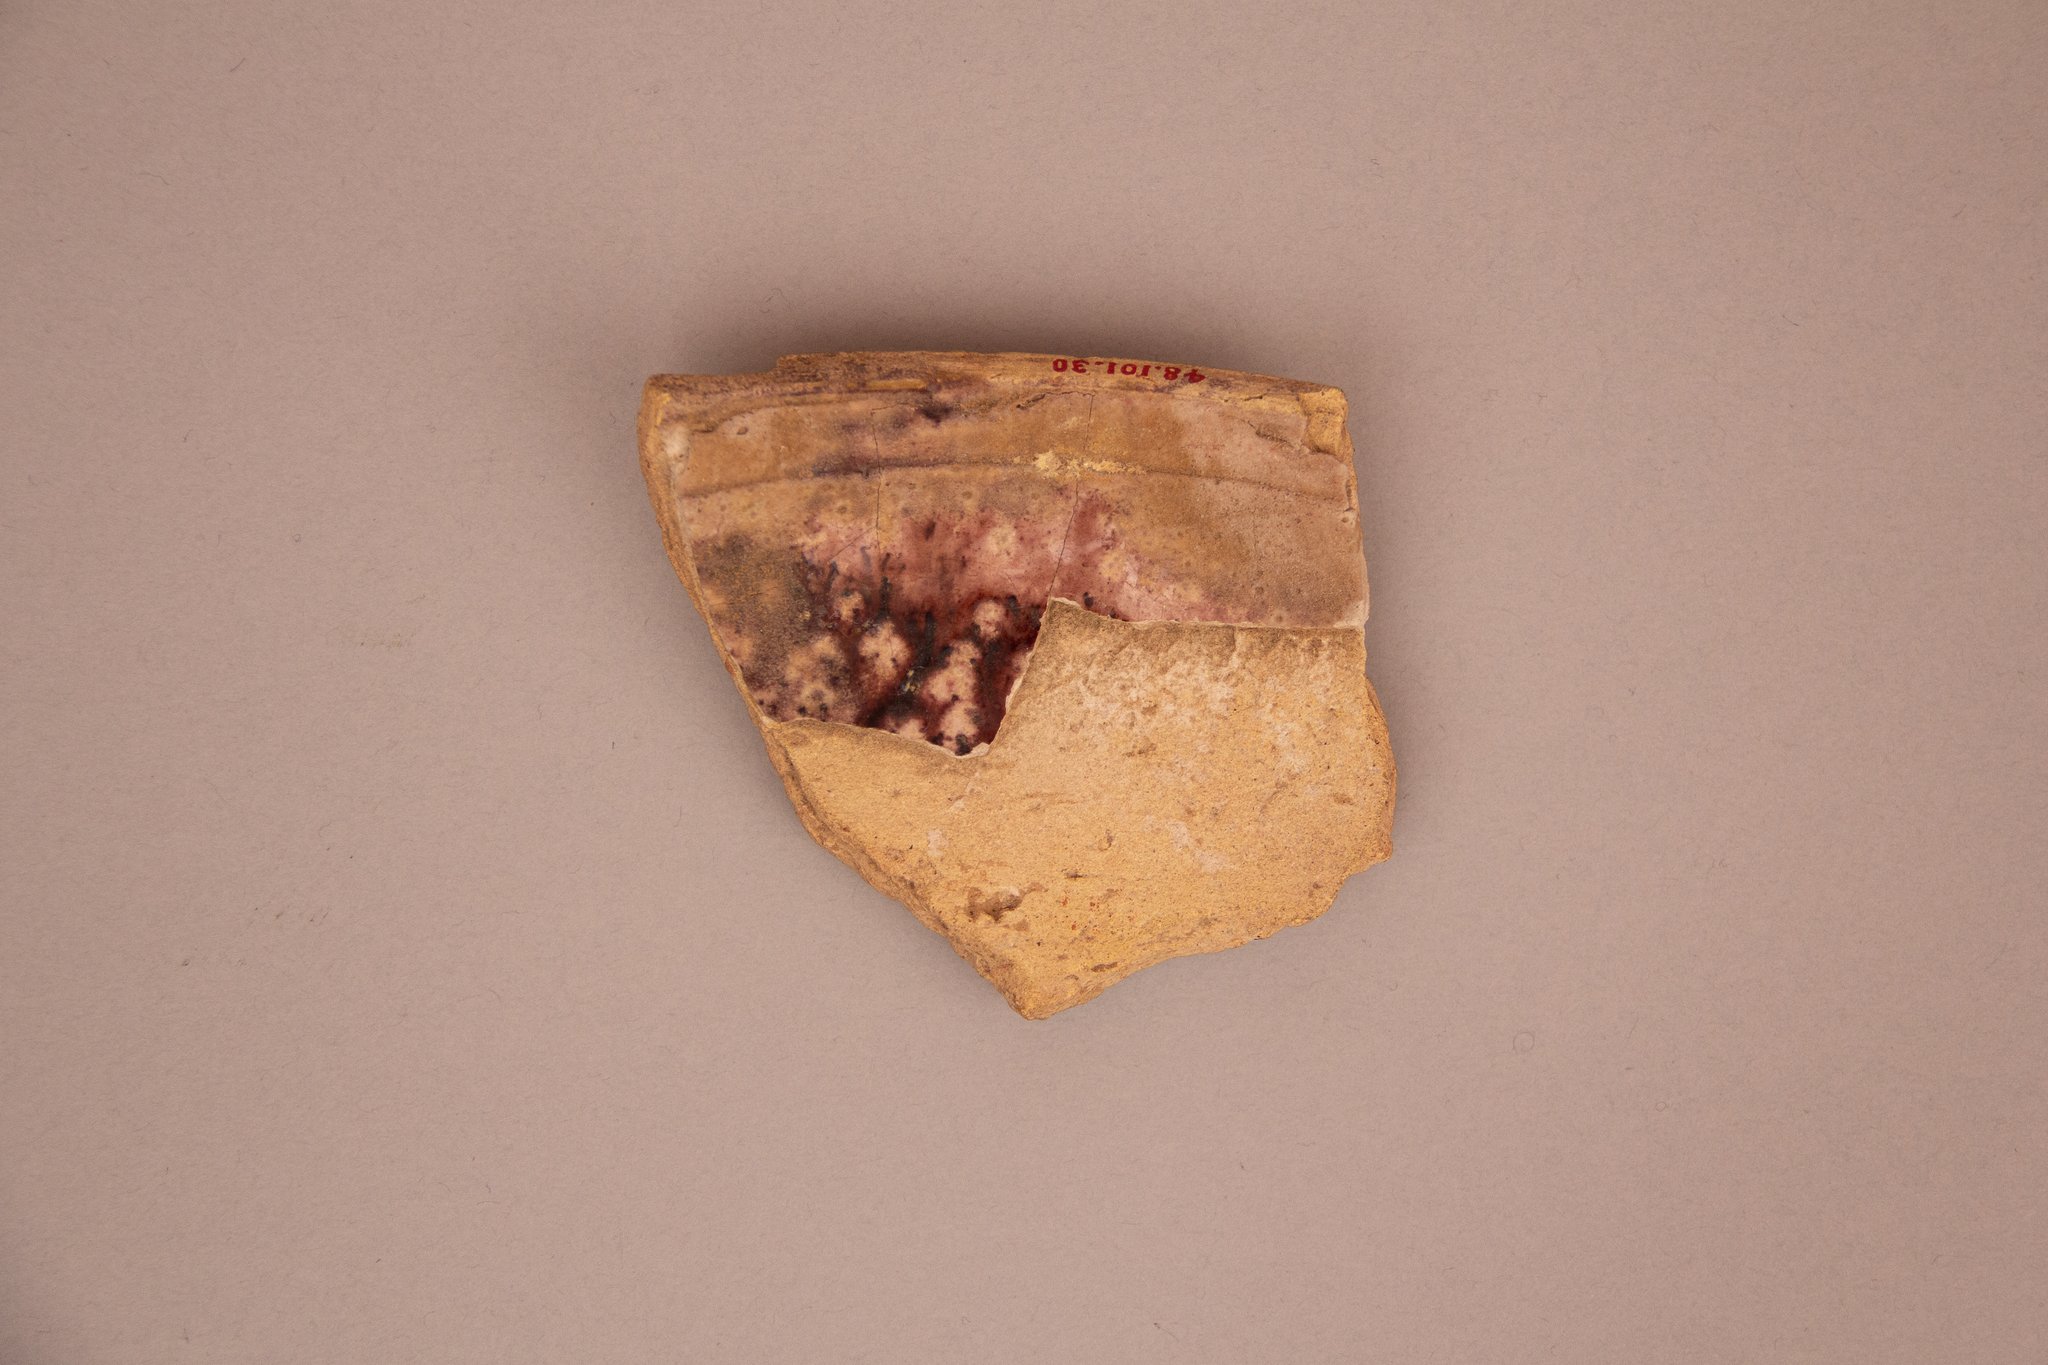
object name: fragment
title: Fragment of Sagger and Bowl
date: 701-1200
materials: earthenware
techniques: glazing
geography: iran